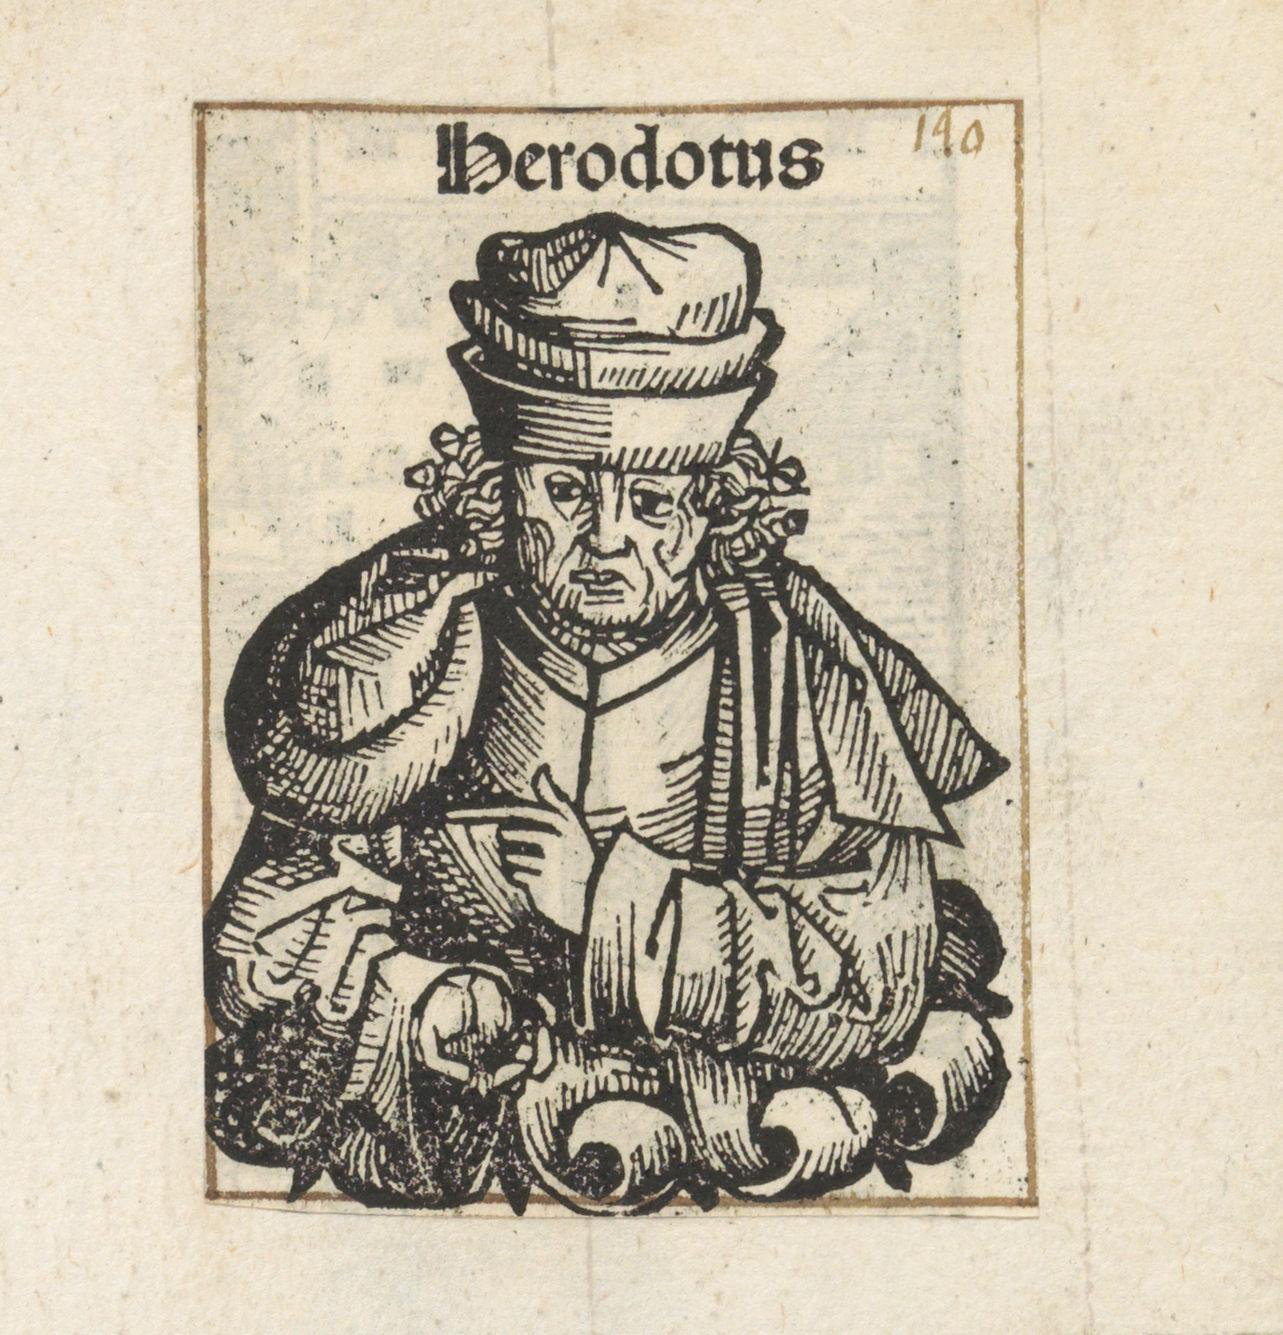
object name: album leaf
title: Herodotus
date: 1493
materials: paper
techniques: letterpress printing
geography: nuremberg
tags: male persons from classical history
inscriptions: inscription: ‘140’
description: De houtsnede wordt gebruikt als boekillustratie in de Liber Chronicarum (of Neurenbergkroniek) van Hartmann Schedel, verschenen in het Latijn en Duits in 1493. Zie de Latijnse uitgave, folio 72v.